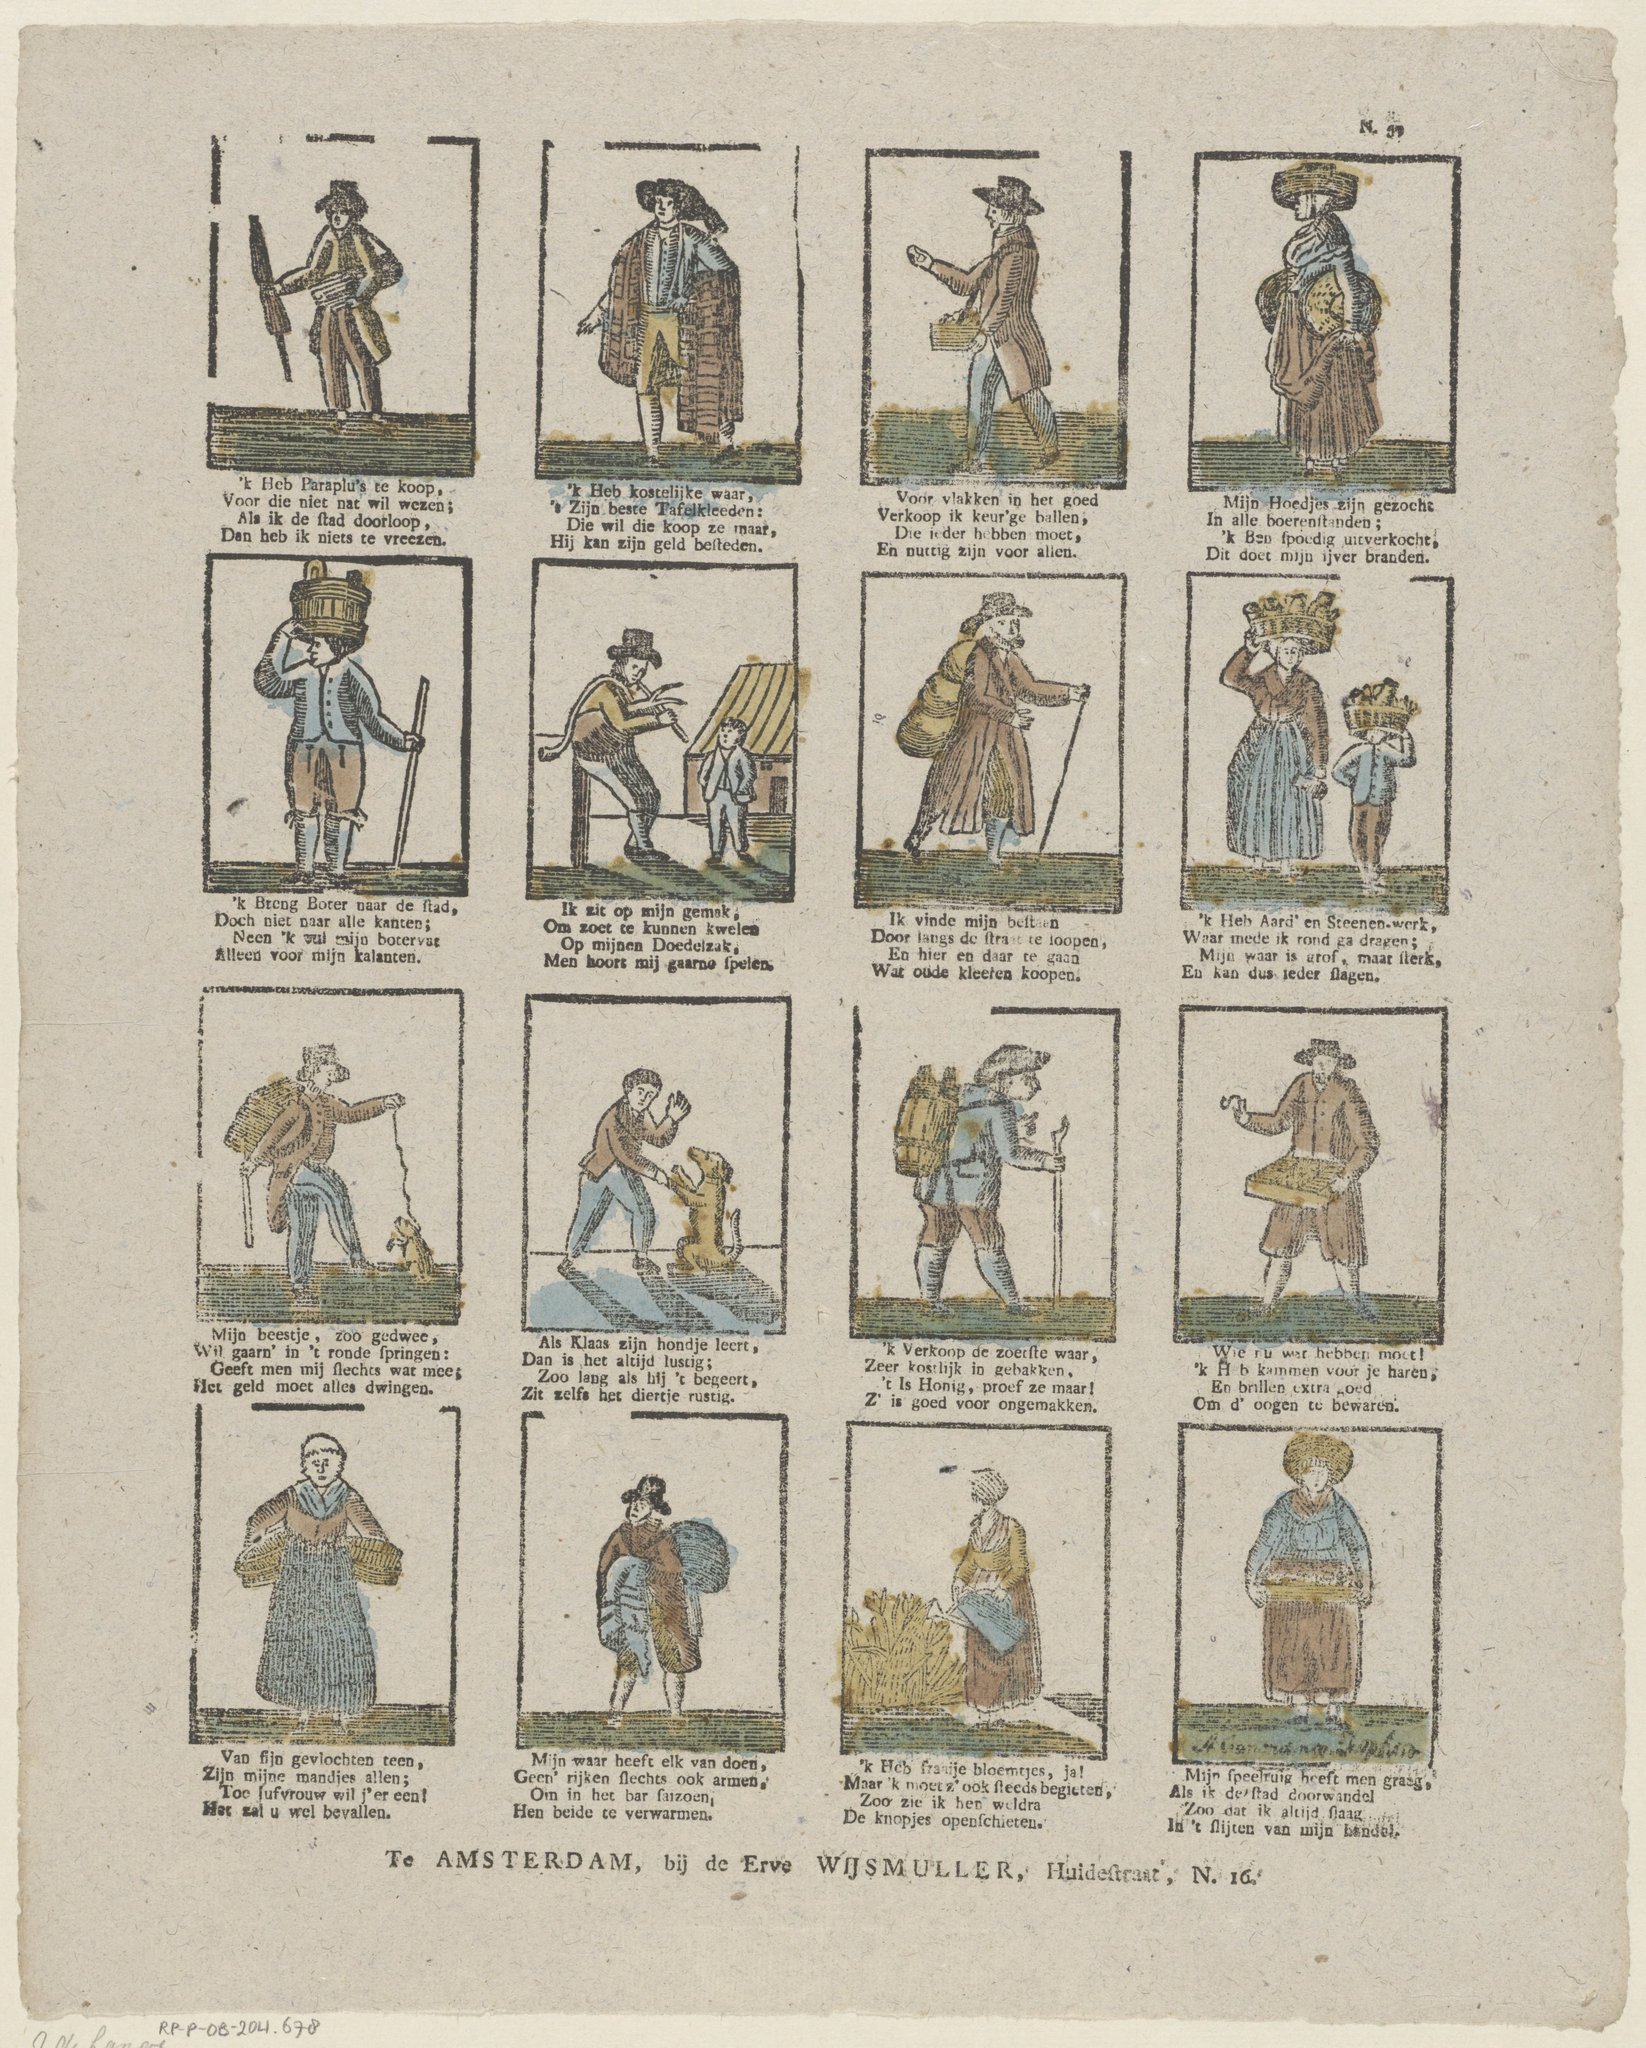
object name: print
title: Figuren en beroepen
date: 1828-1849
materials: paper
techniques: colour, letterpress printing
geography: amsterdam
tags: musician at work, human types, street-trader, merchant, salesman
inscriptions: collector's mark: Lugt 2760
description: Blad met 16 voorstellingen van figuren en beroepen, zoals een straatverkoper, een doedelzakspeler en een vrouw die de planten water geeft. Onder elke afbeelding een vierregelig vers. Genummerd rechtsboven: N 59.